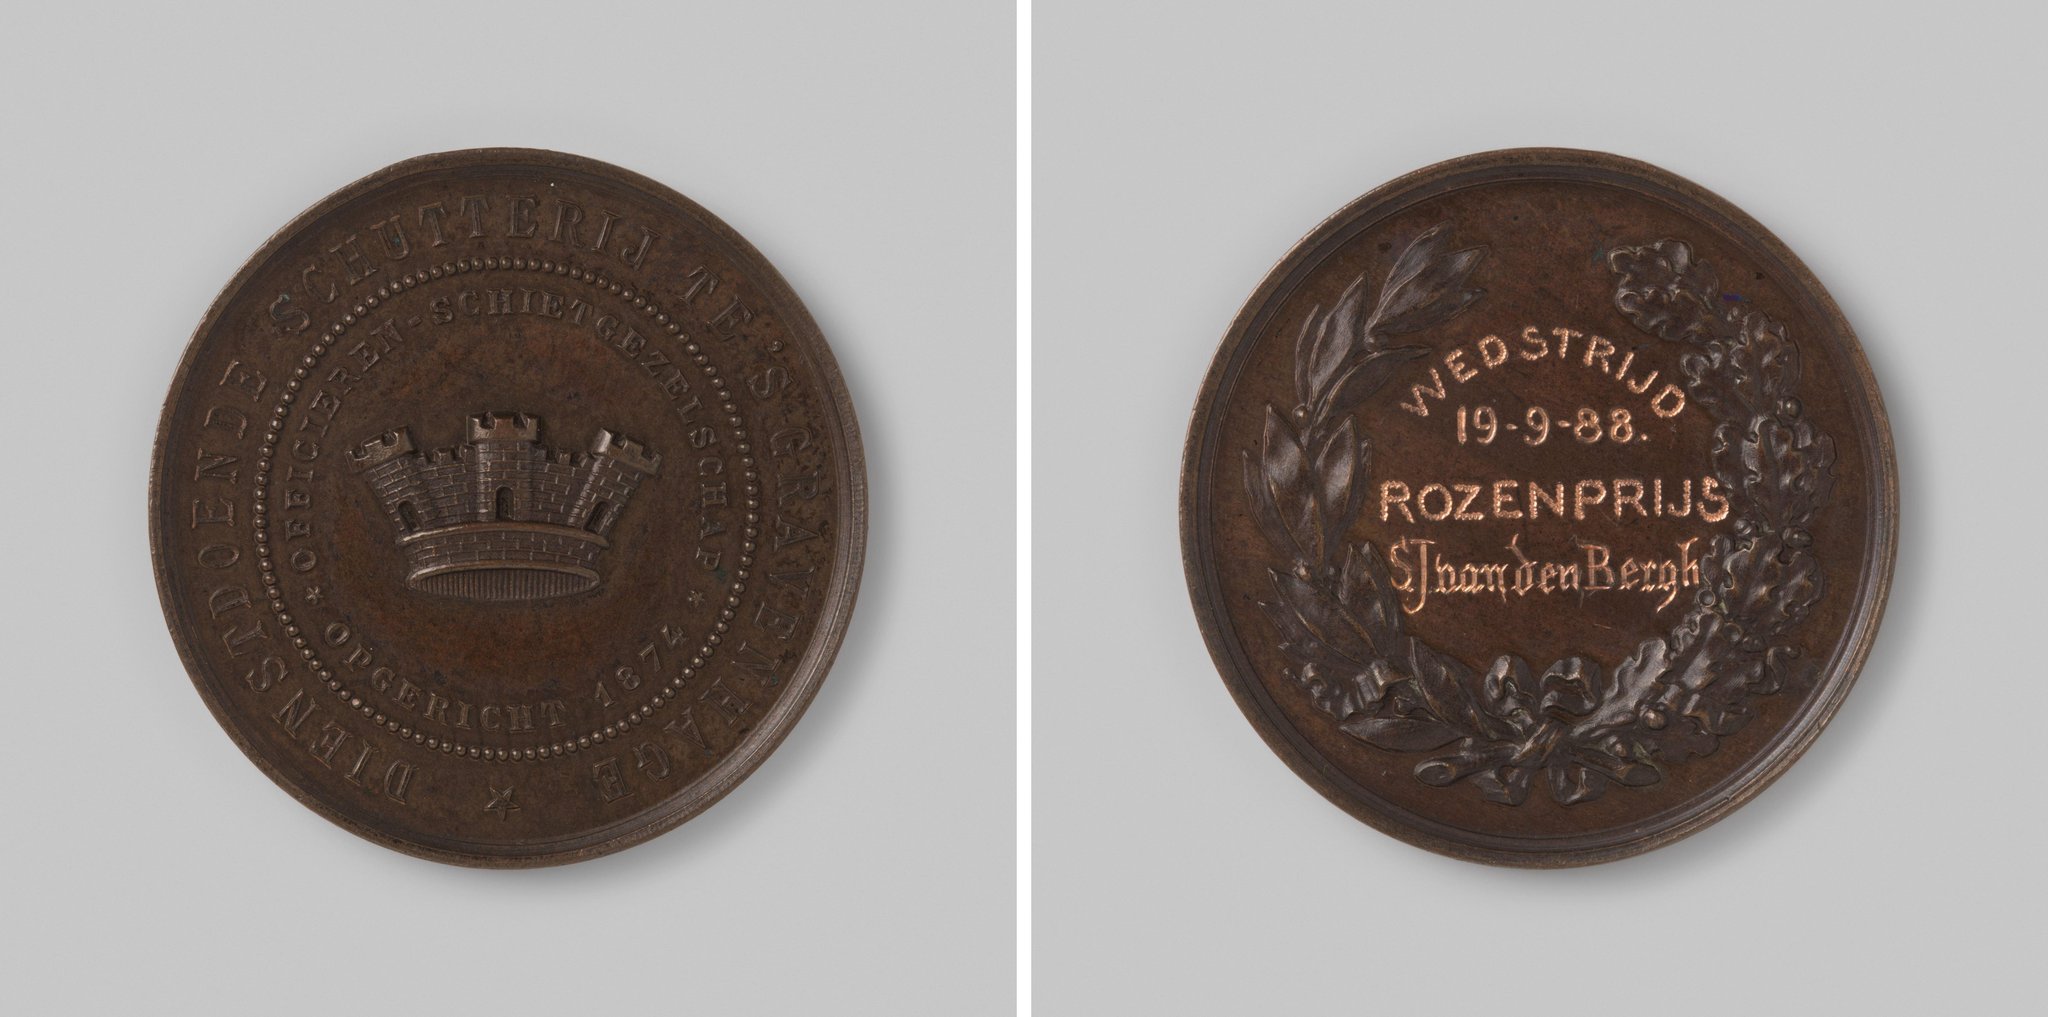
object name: history medal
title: Prijspenning van het Officieren Schietgezelschap van de Dienstdoende Schutterij te 's-Gravenhage (1874)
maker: wurden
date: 1874-1888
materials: bronze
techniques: striking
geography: brussels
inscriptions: inscription: ‘WEDSTRIJD / 19-9-88. / ROZENPRIJS / S.J. van den Bergh’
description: Bronzen penning, op de voorzijdeeen muurkroon met dubbel omschrift, gescheiden door een parelcirkel, op de keerzijde een inscriptieruimte tussen samengstrikte lauwer- en eikentakken.